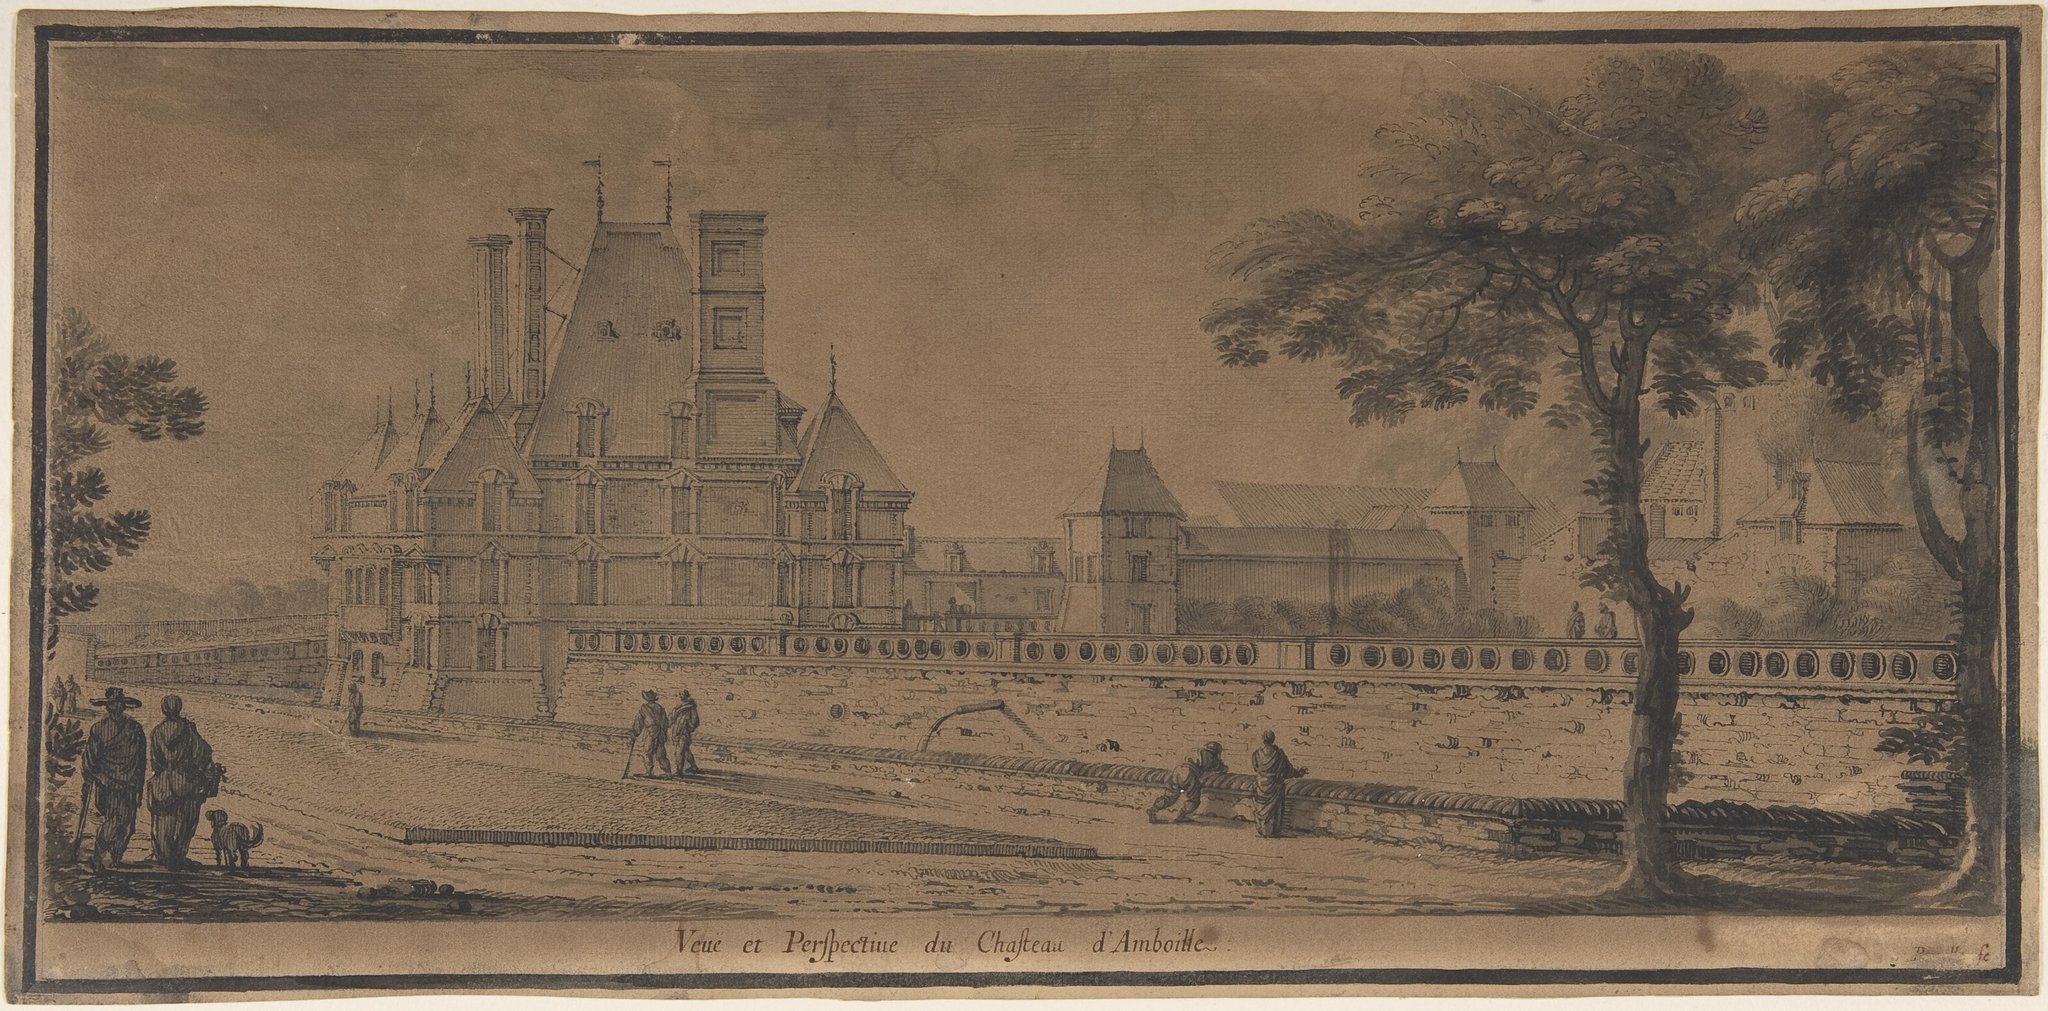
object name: drawing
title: Veue et Perspective du Chasteau d'Amboille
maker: nicolas perelle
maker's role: artist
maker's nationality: french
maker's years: 1631-1695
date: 1631-1695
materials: ink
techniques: brush, pen, wash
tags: human figures,buildings,roads,trees